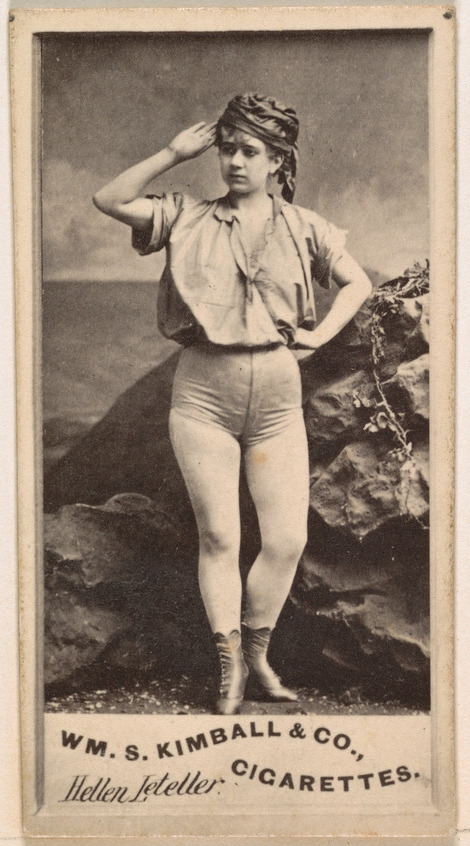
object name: photograph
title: Hellen Leteller, from the Actresses series (N203) issued by Wm. S. Kimball & Co.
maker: william s. kimball & company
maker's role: publisher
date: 1889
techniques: color lithograph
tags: portraits,women,actresses